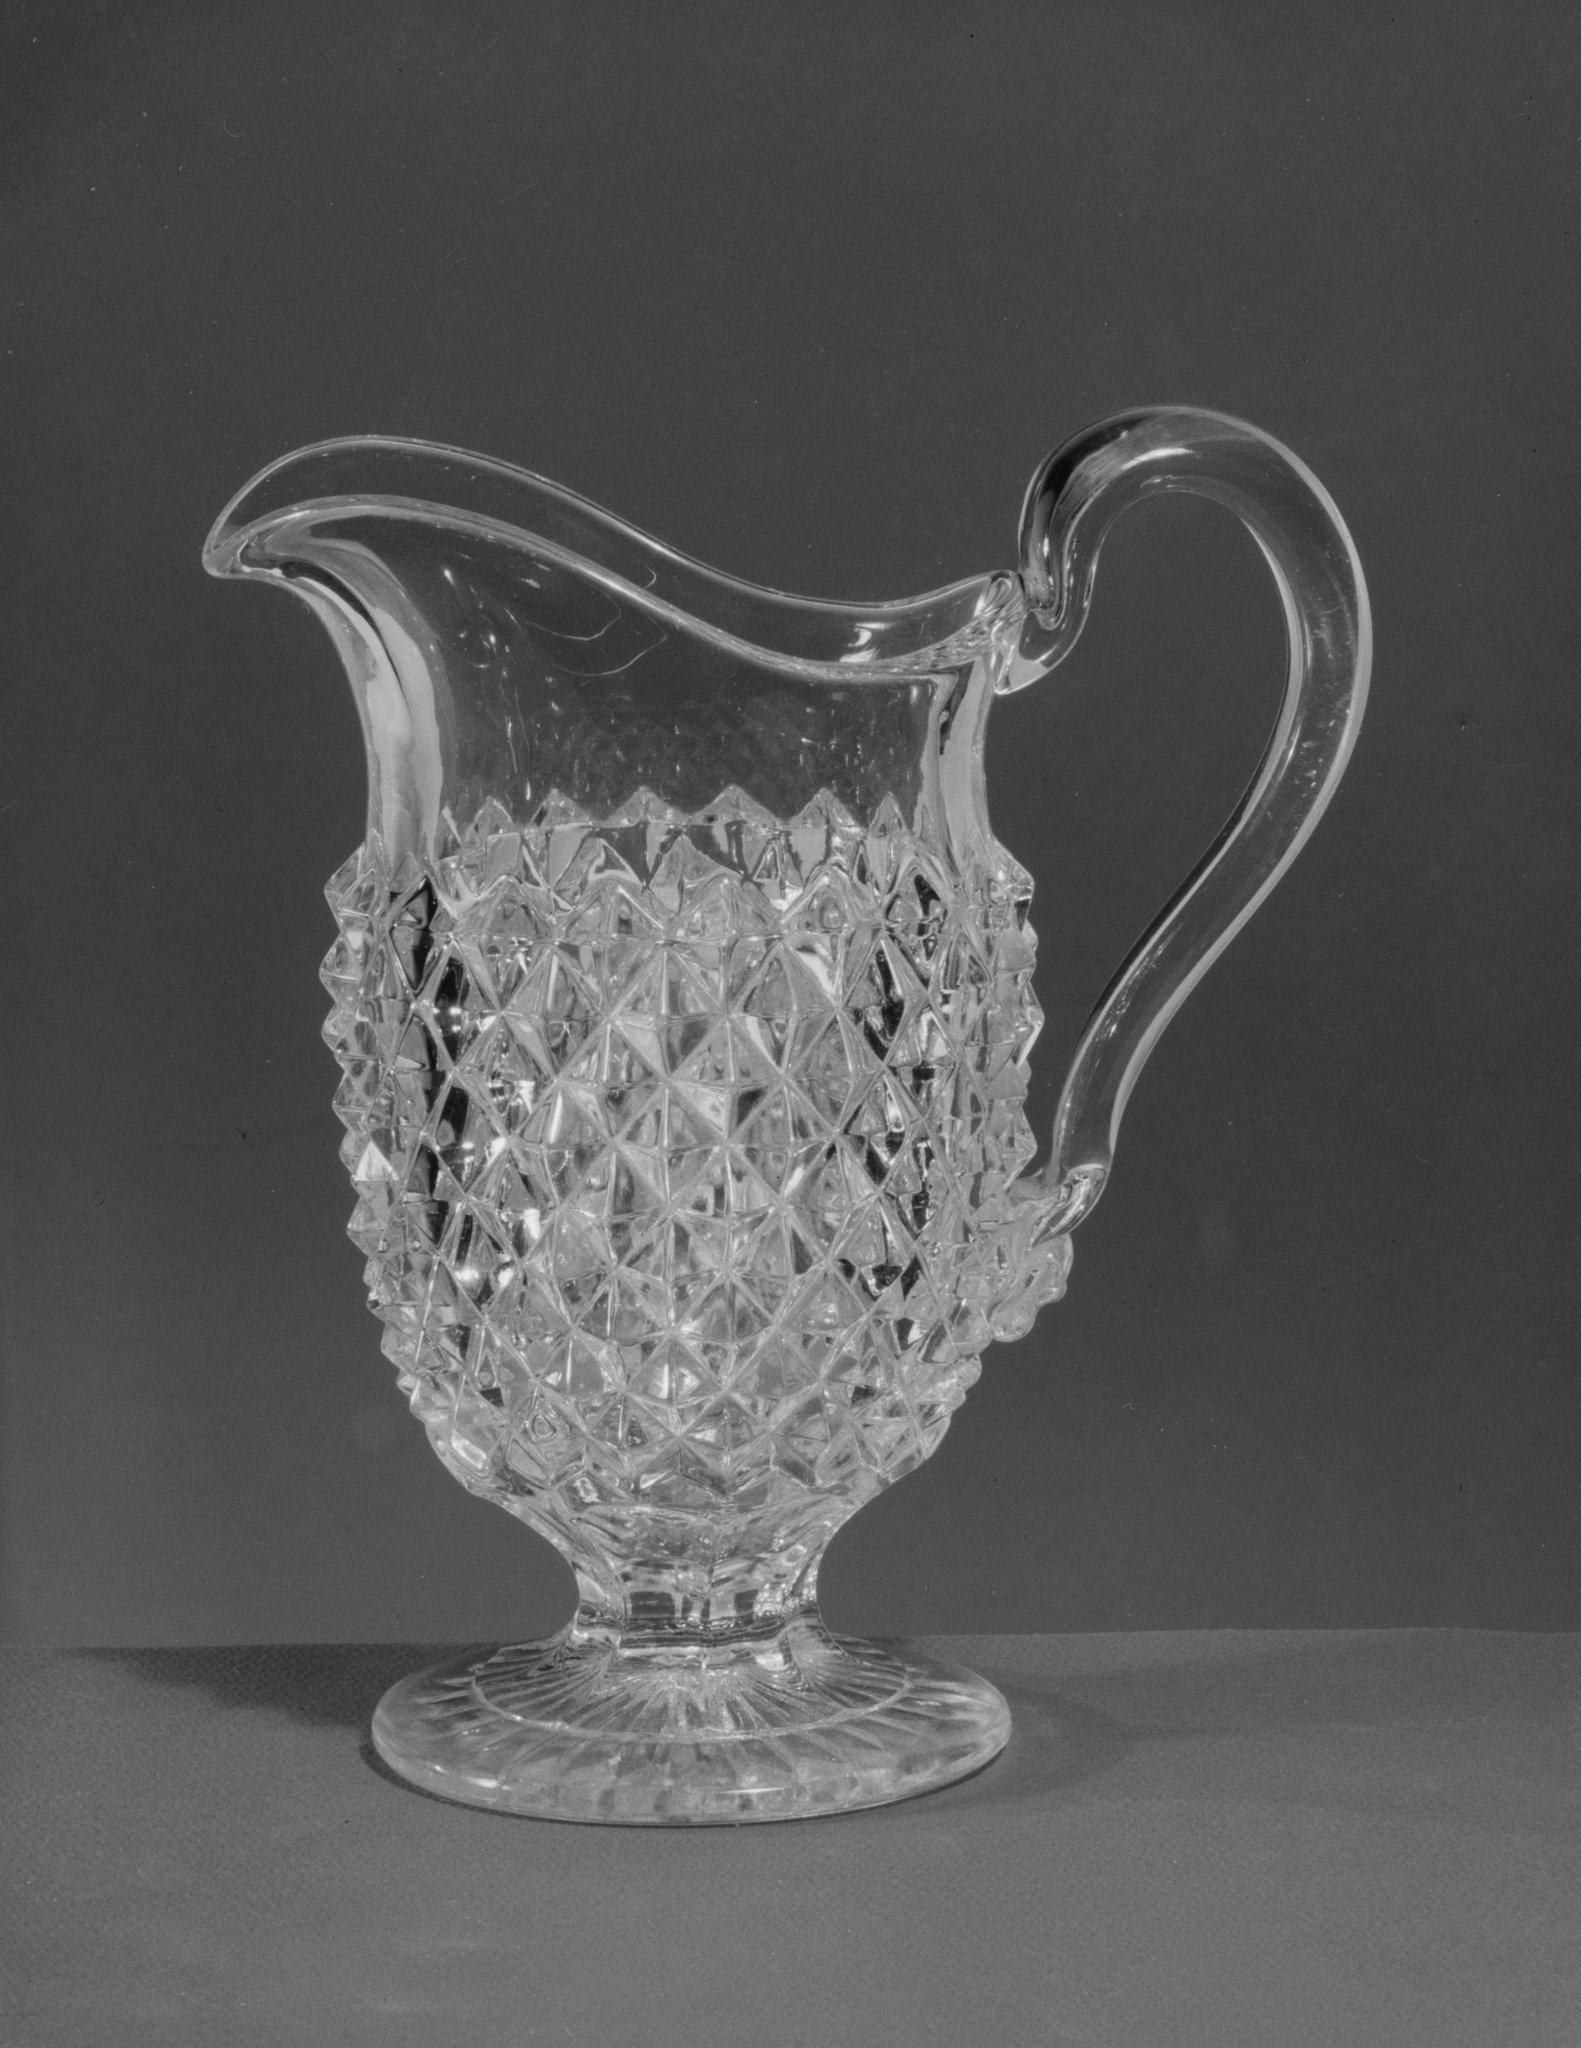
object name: cream pot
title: Creamer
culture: american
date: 1860-1870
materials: glass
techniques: pressed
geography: united states